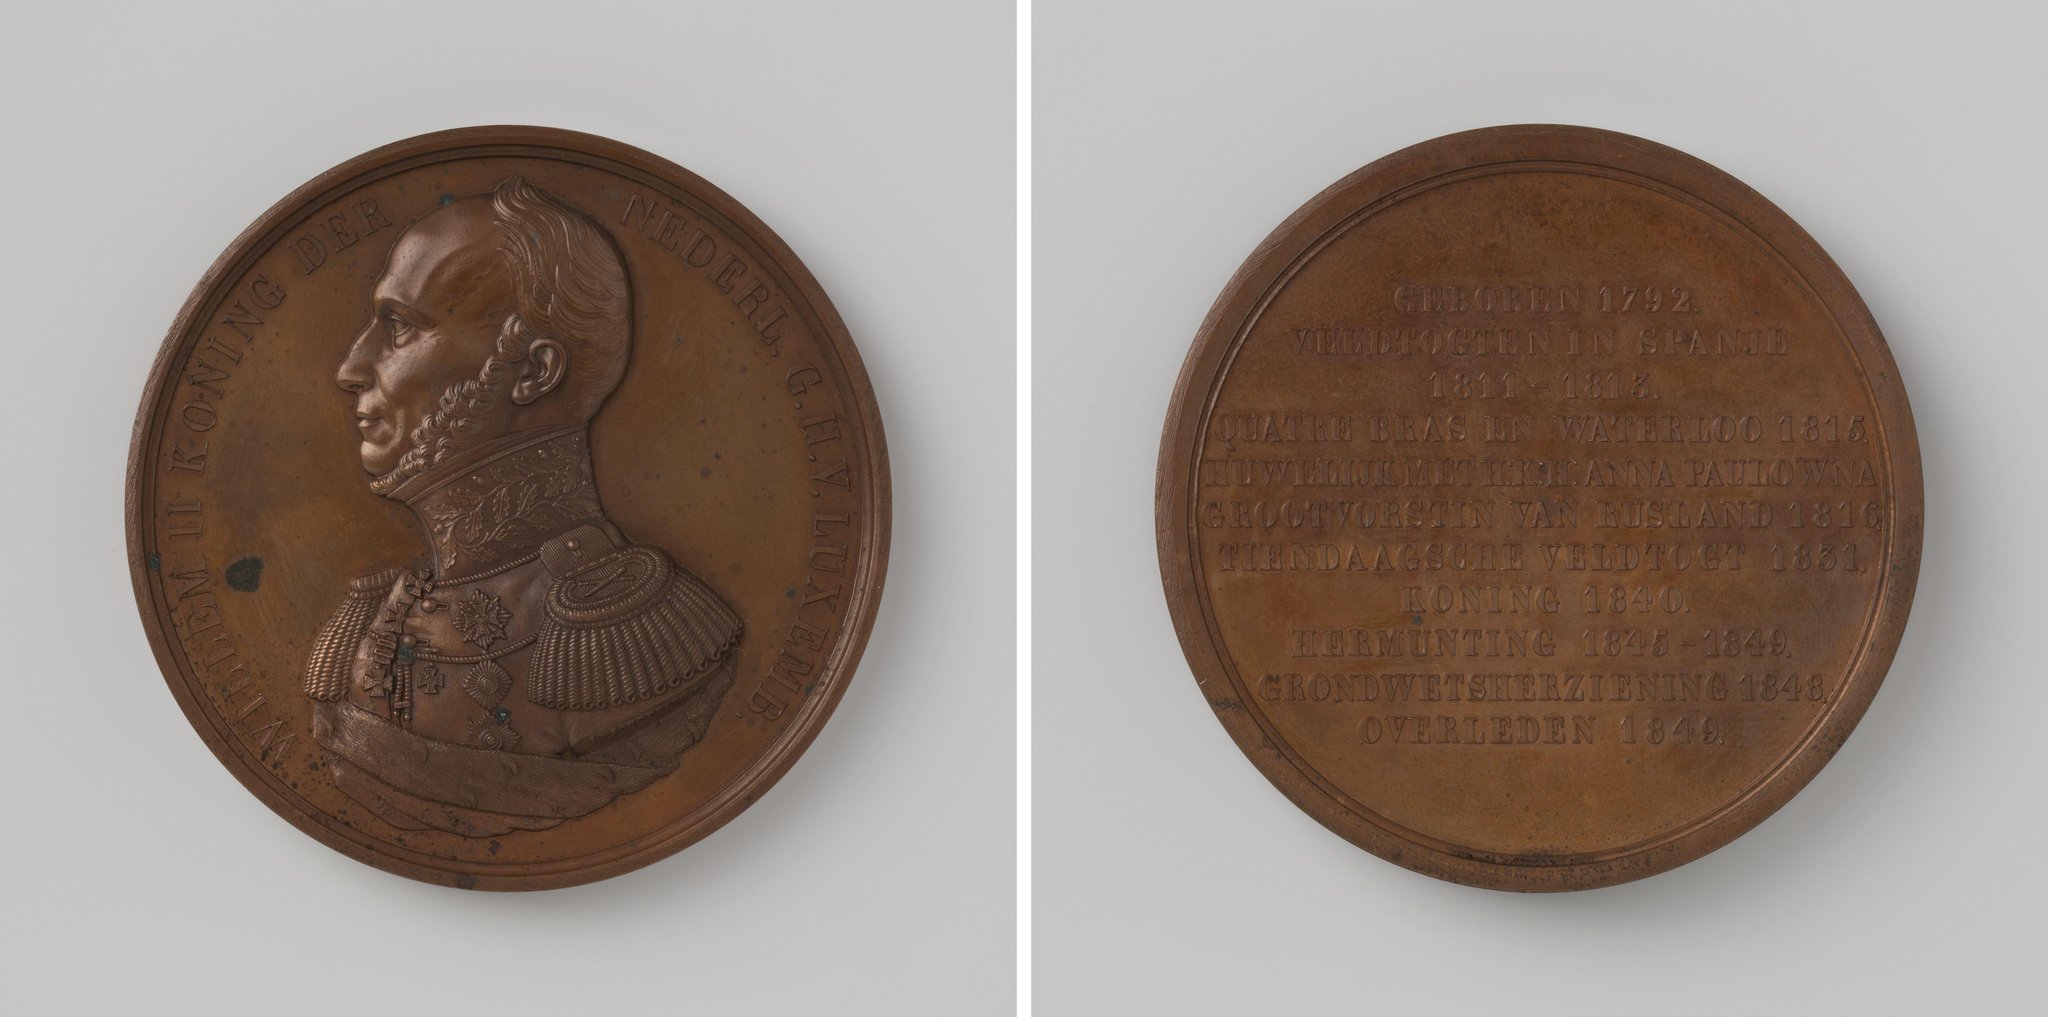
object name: history medal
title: Overlijden van Koning Willem II 1849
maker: johannis petrus schouberg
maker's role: die cutter, draughtsman, print maker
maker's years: 1798-1864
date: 1849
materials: bronze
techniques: striking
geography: utrecht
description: Bronzen penning, op de voorzijde het geuniformeerde borstbeeld van Willem II naar links met omschrift, op de keerzijde elf regels tekst.